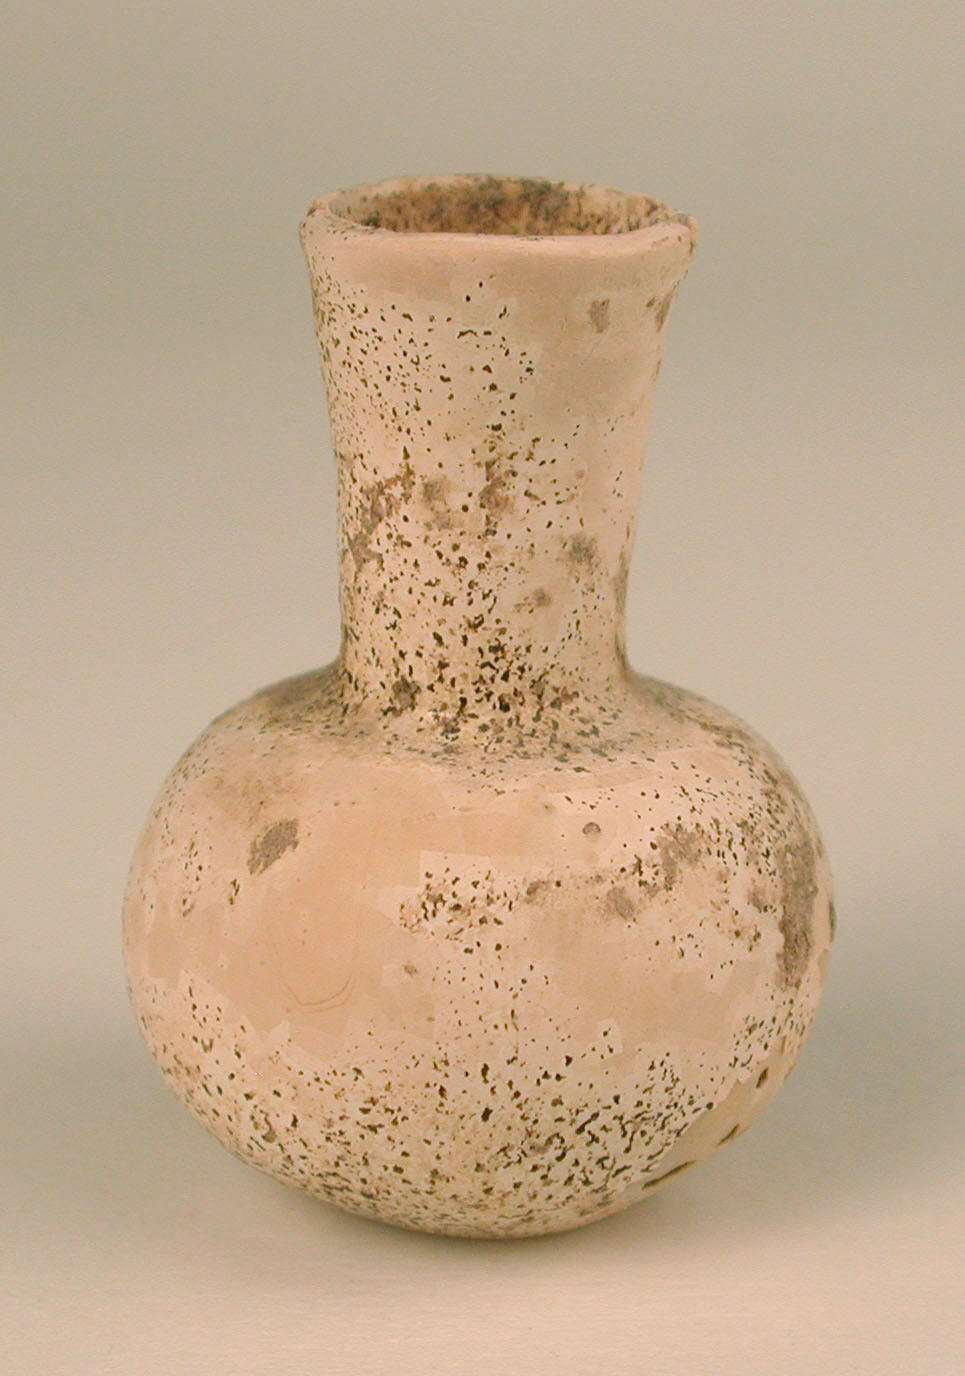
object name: bottle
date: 801-1000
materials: glass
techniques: glassblowing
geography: iran